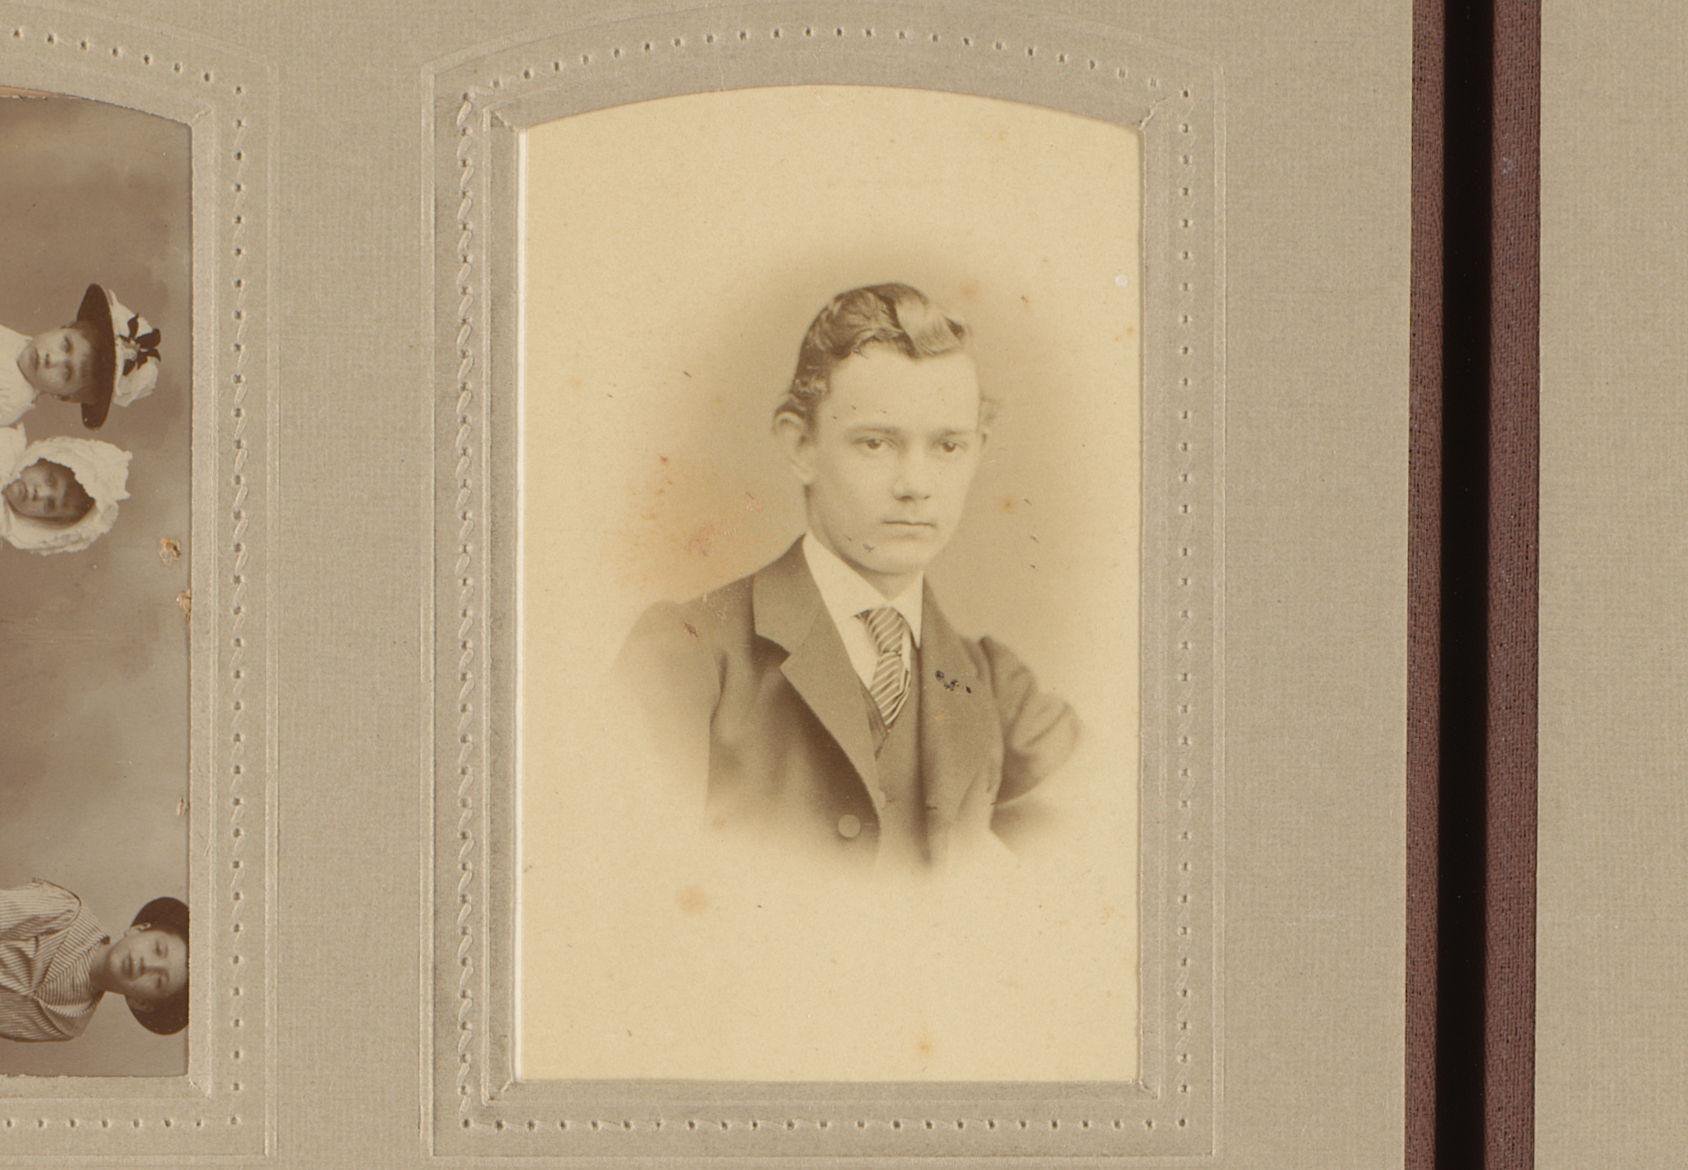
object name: carte de visite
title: Studioportret van Karel Wiggers van Kerchem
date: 1885-1890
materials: paper, photographic support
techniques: albumen print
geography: amsterdam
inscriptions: title: ‘Karel Wiggers van Kerchem’